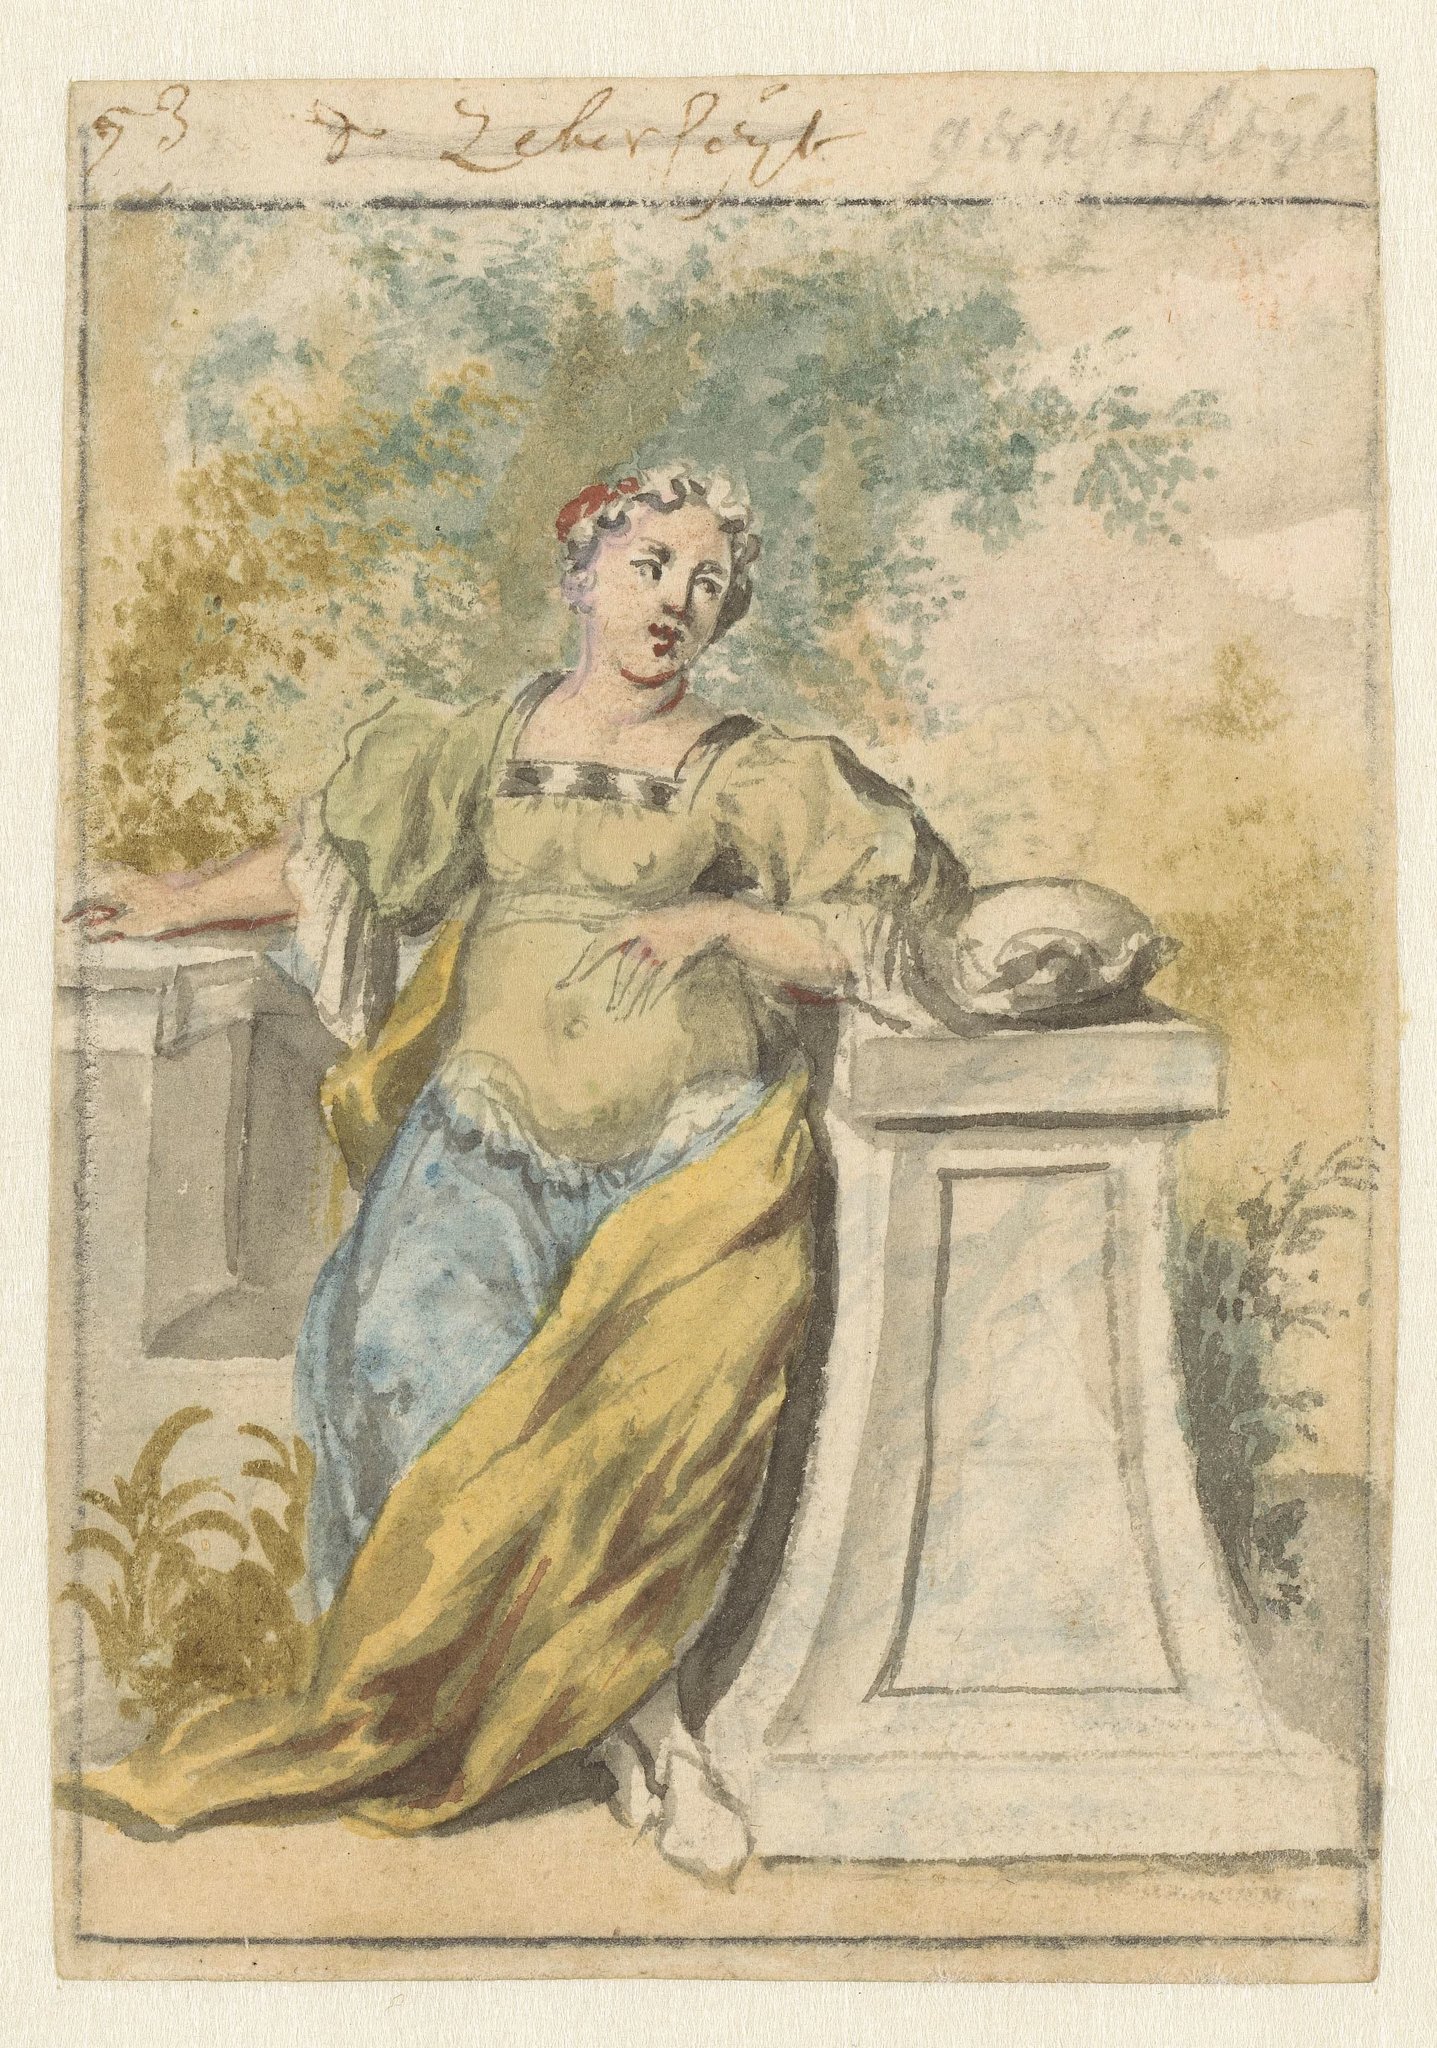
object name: drawing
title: Uitbeeldingen van karakters, eigenschappen, deugden en ondeugden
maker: pieter van den berge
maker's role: draughtsman, print maker, printer, publisher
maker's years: 1659-1737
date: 1675-1737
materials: chalk, graphite, ink, paper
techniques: brush, pen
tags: certainty (+ personification)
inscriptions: number: ‘53’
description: Een vrouw, en face, op een marmeren bank gezeten.